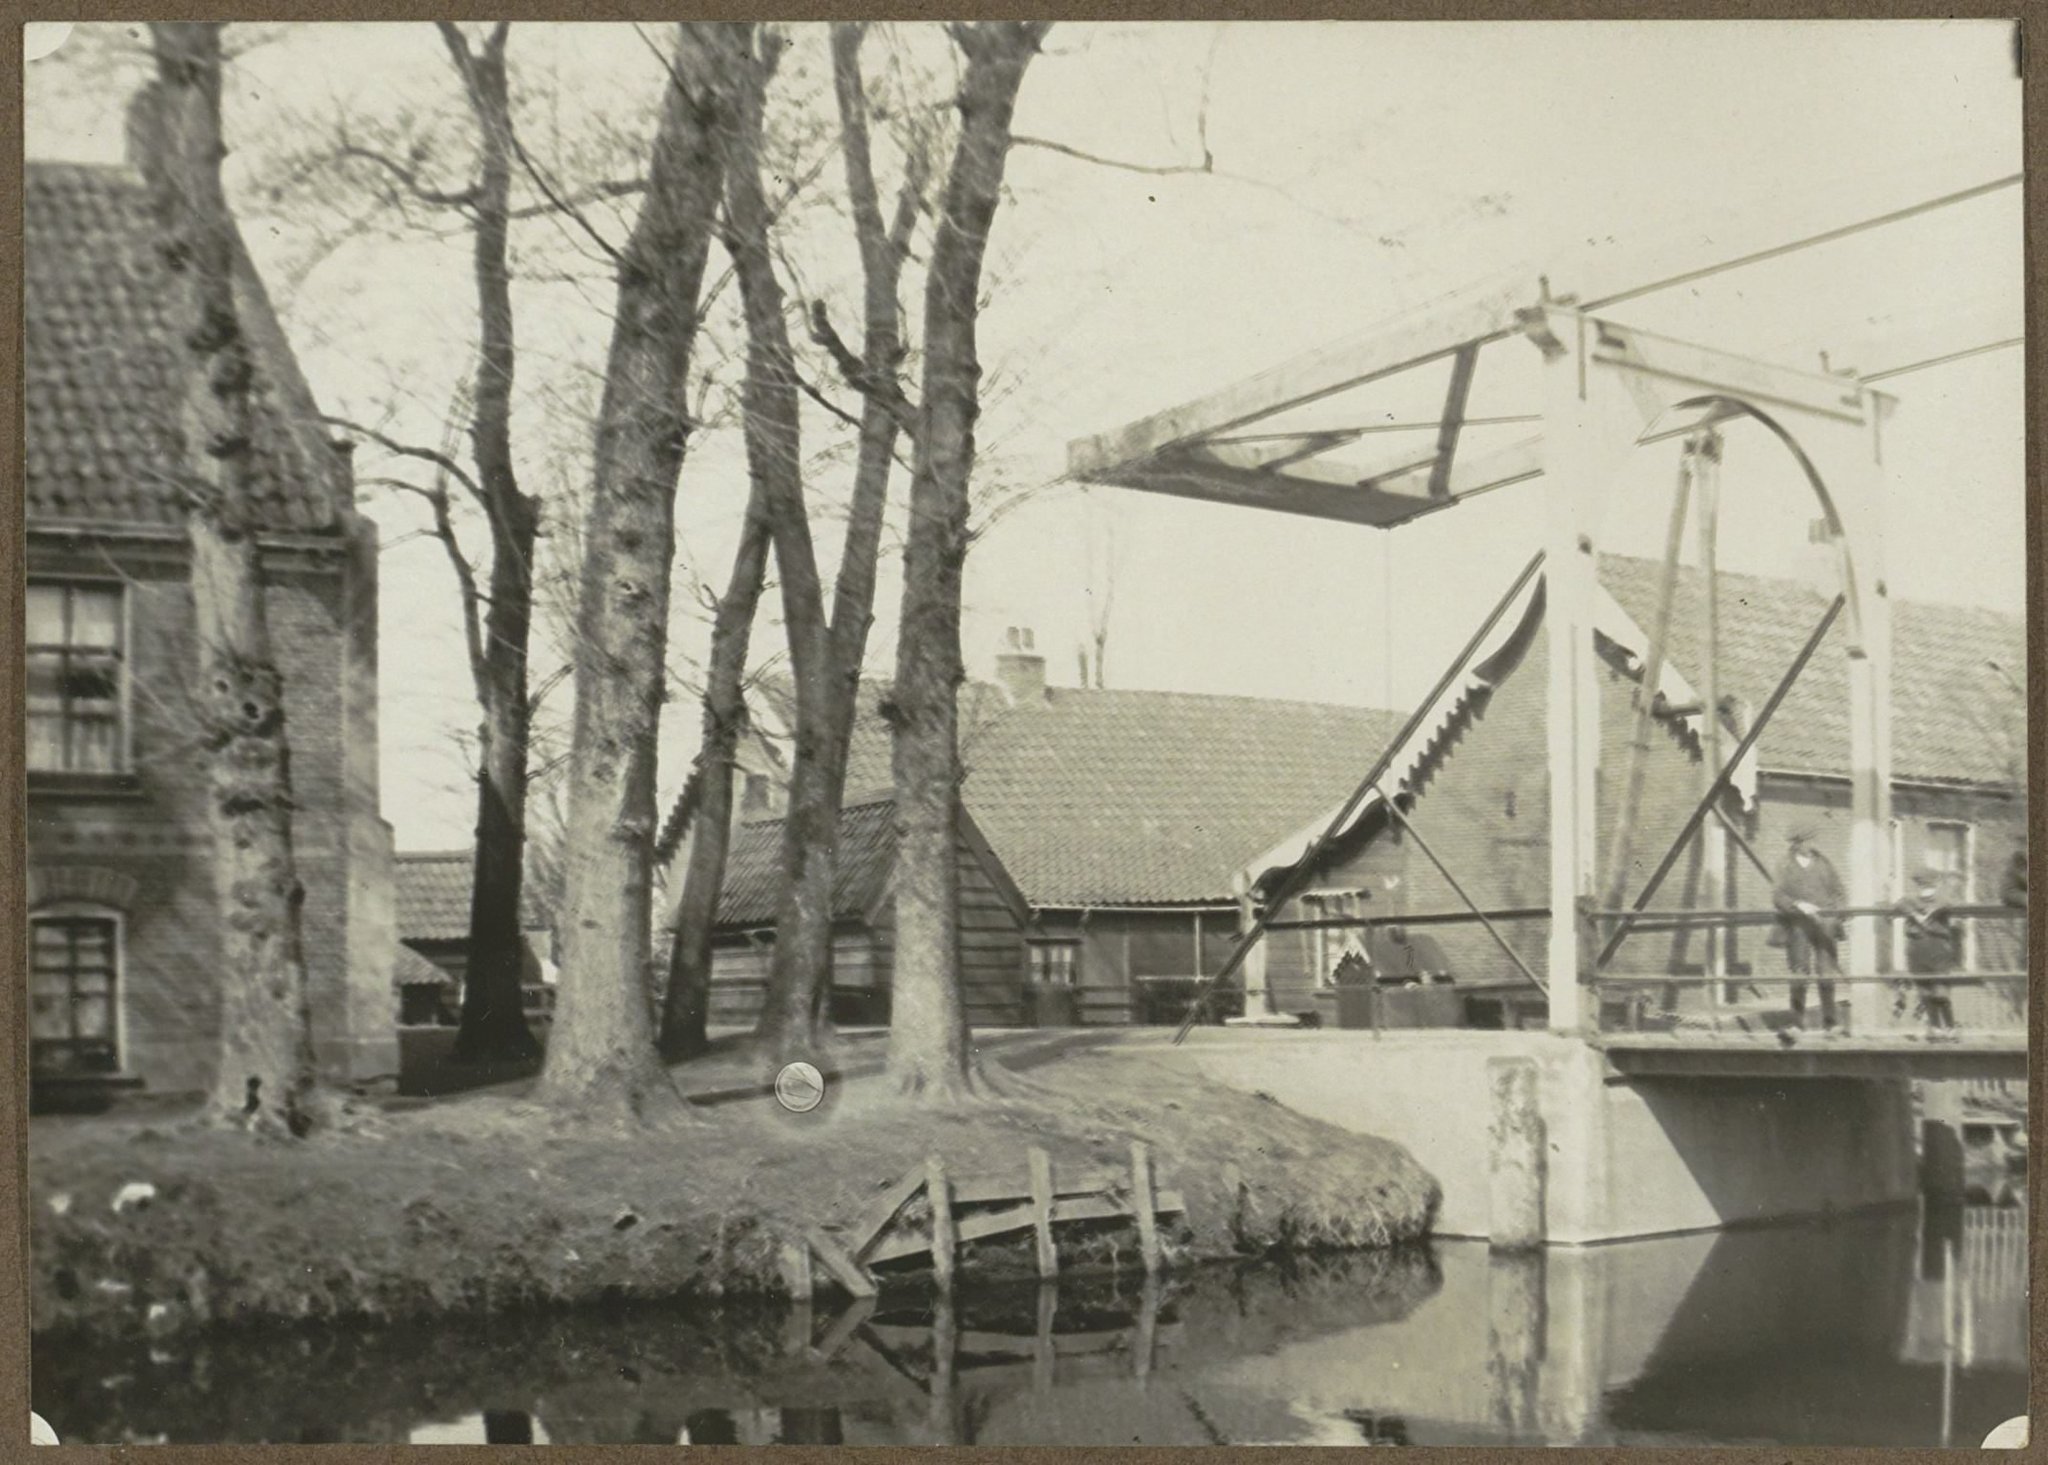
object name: photograph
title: Brug over het water aan de Sloterweg in Amsterdamn (Katzenbrug)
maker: Anonymous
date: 1910-1930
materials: paper, photographic support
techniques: gelatin silver print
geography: sloten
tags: bridge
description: Onderdeel van Album met foto's van Amsterdam en omgeving.